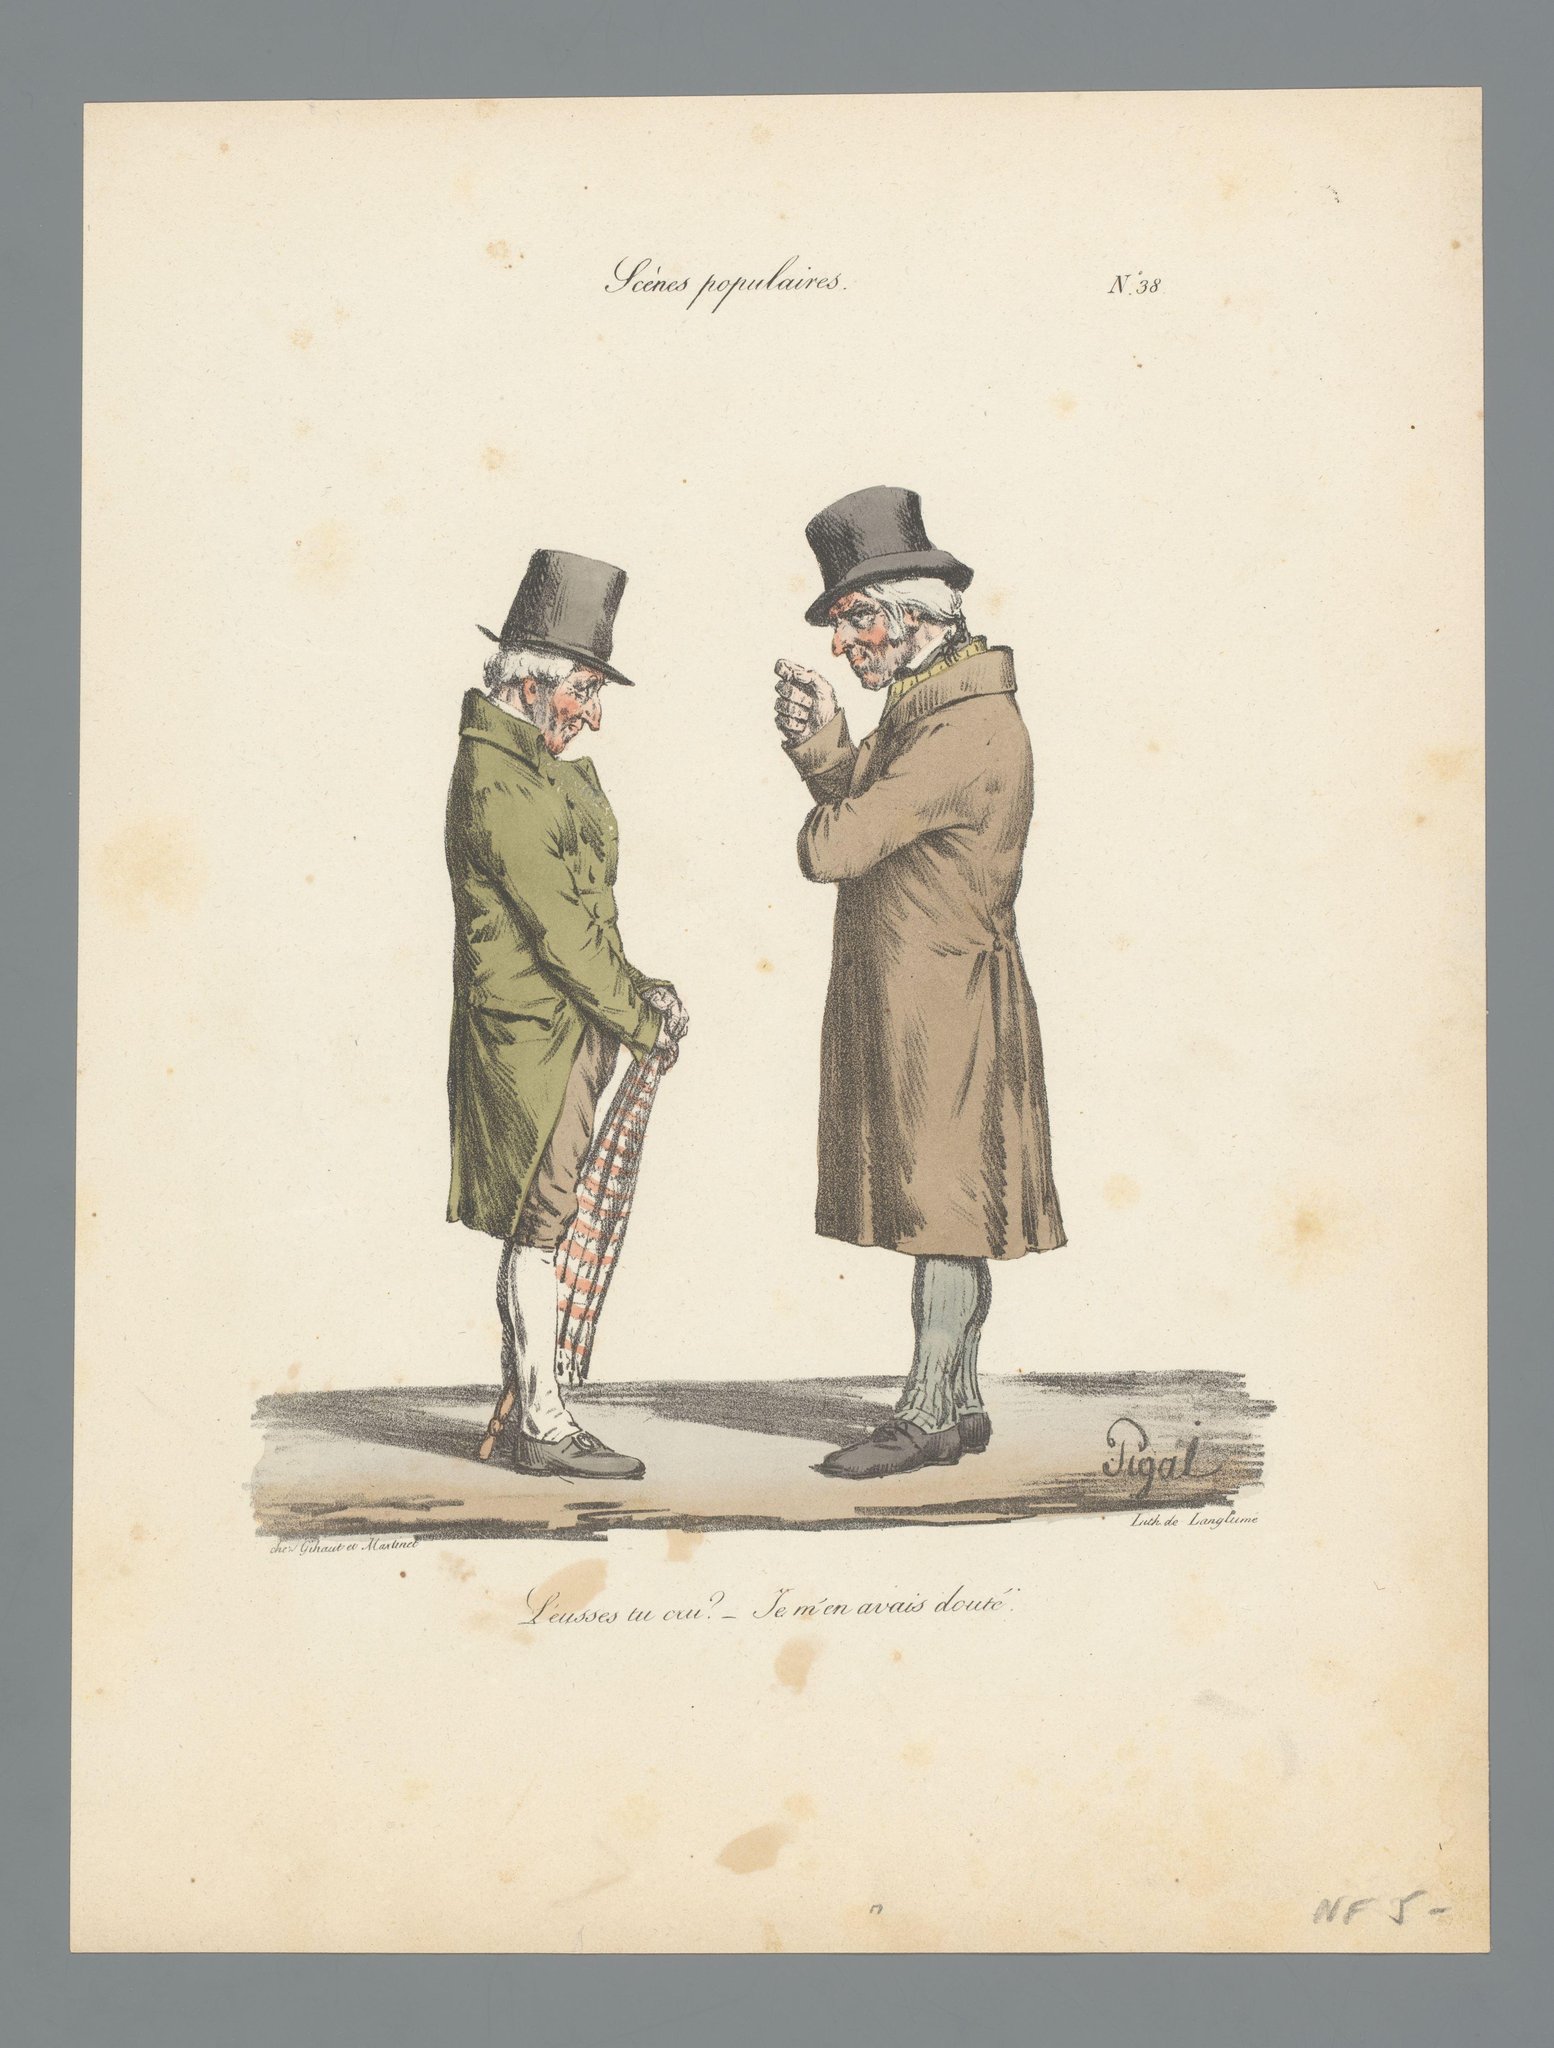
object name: print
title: Voorvallen onder het volk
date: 1823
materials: paper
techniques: hand coloring, lithograph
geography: paris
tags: adult man ( + one person)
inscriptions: inscription: ‘Paul Pronté, 74 Rue de Seine/ 30 Dec. 1964. NF 5.-’, collector's mark: Lugt 2228